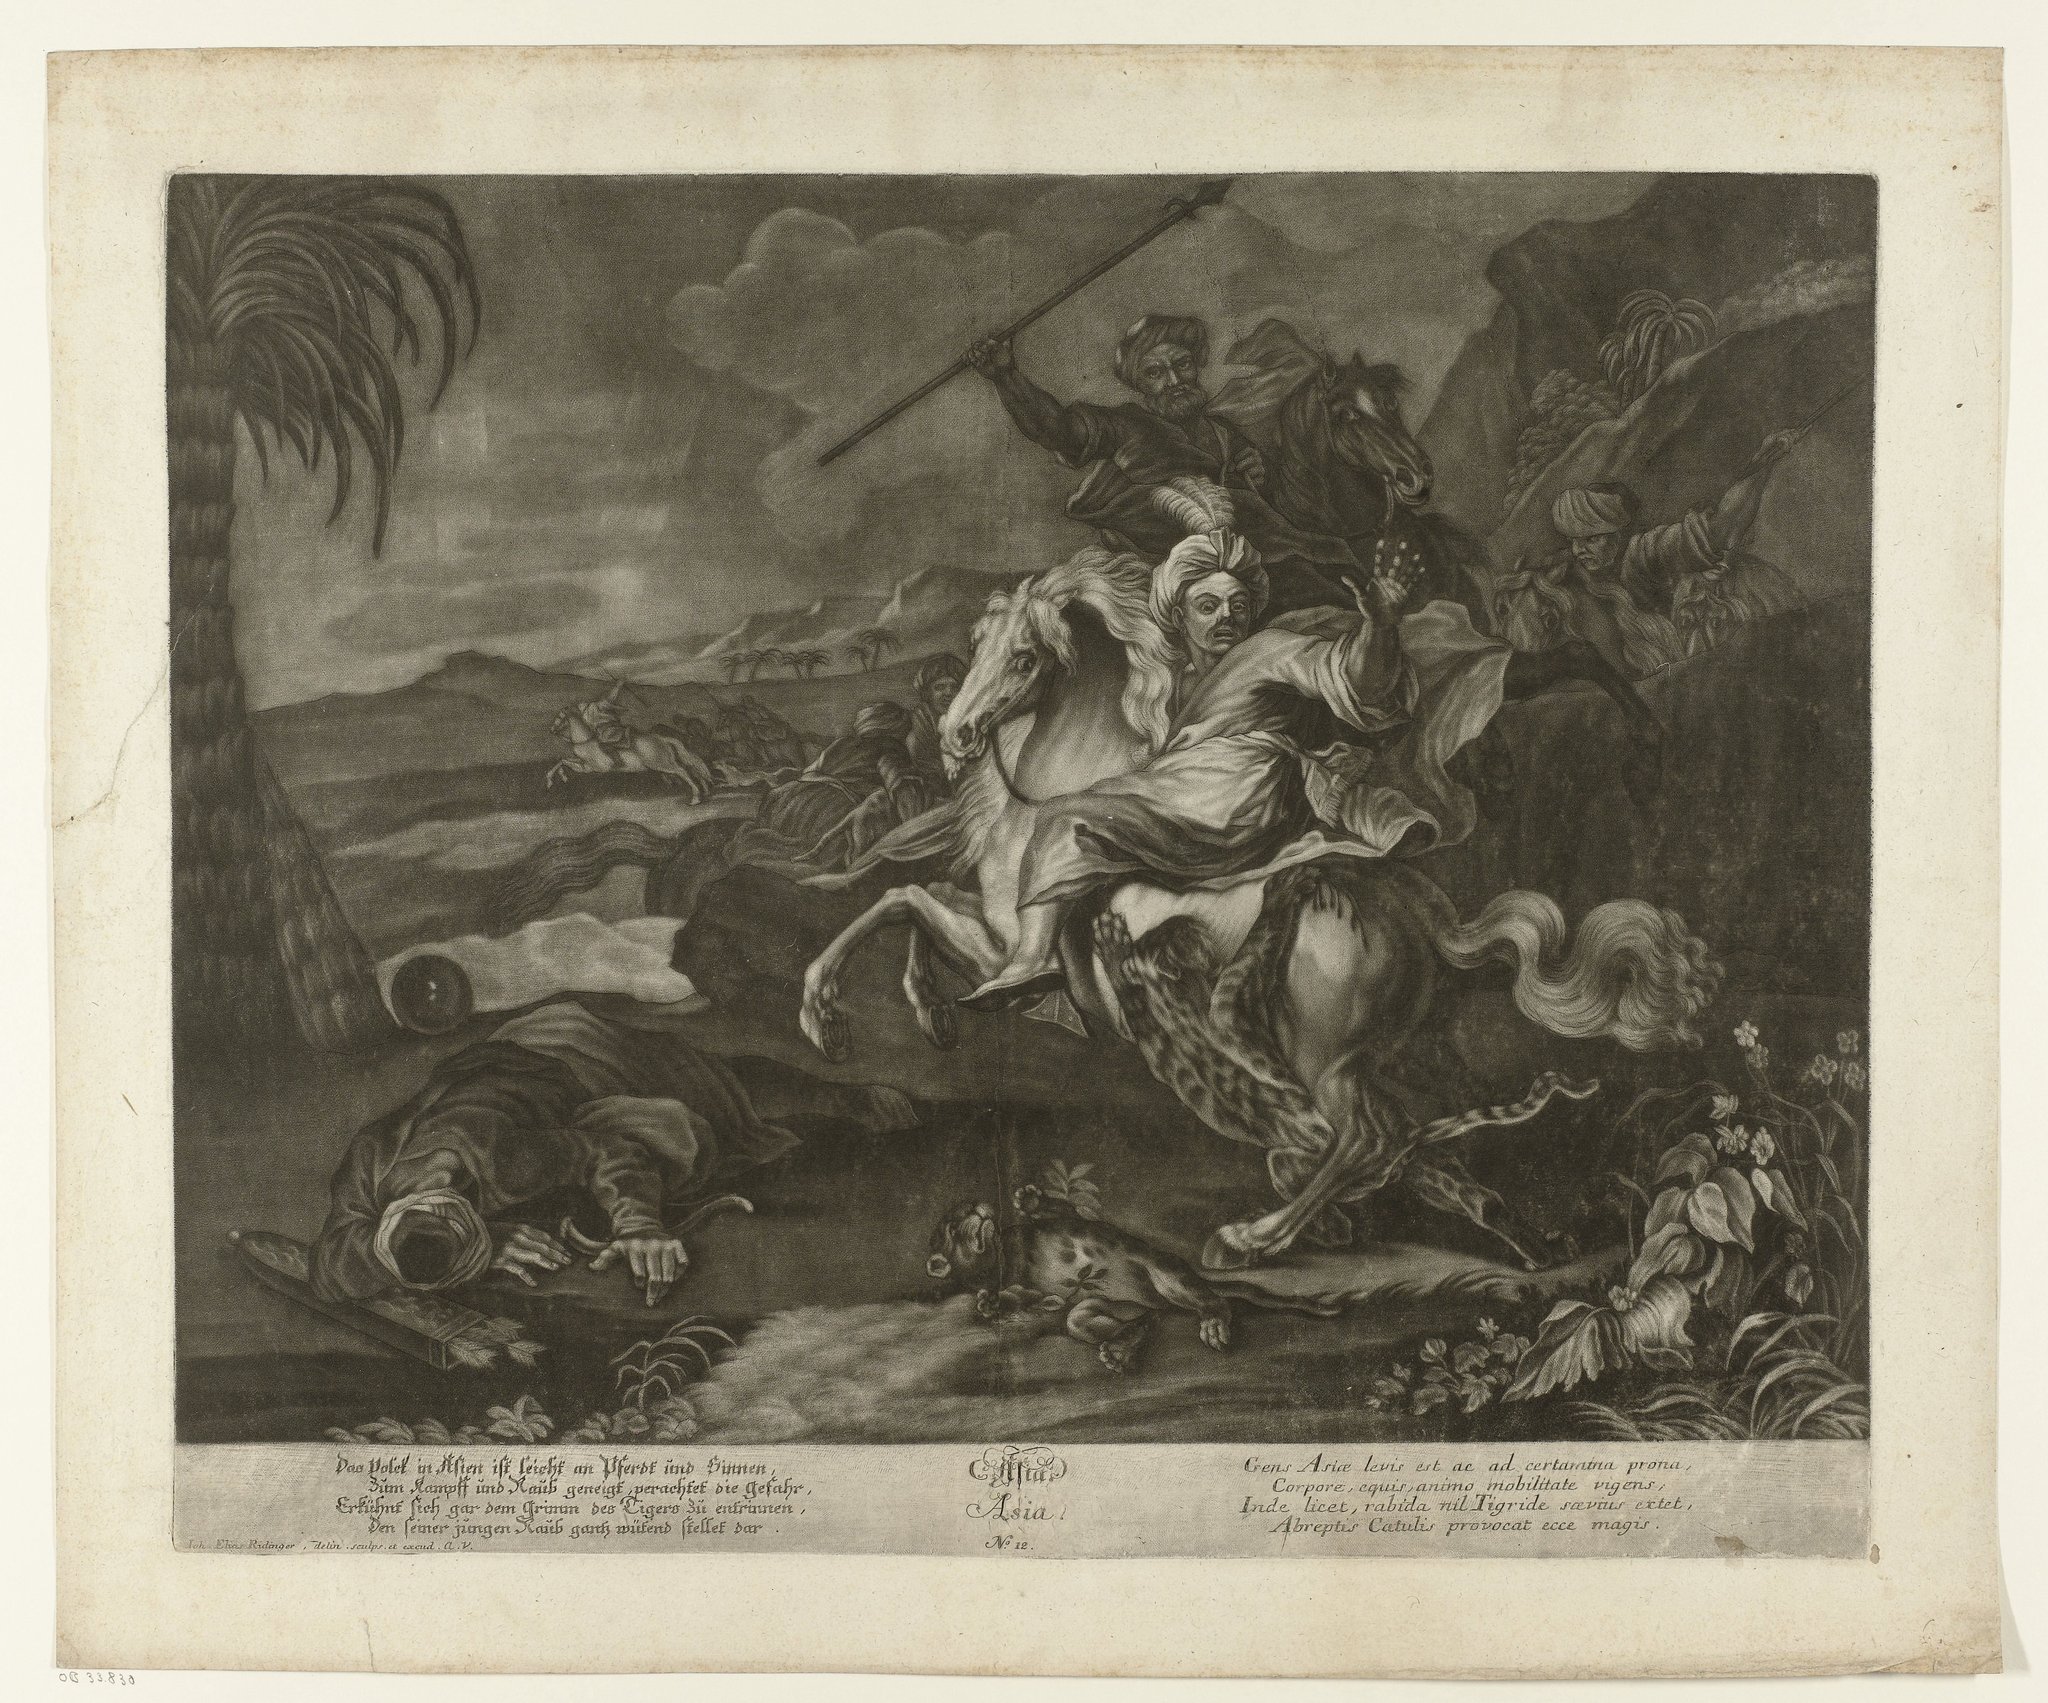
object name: print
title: Asia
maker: johann elias ridinger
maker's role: draughtsman, painter, print maker, publisher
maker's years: 1698-1767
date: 1708-1767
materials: paper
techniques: etching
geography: augsburg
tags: beasts of prey, predatory animals: leopard, asia represented allegorically; 'asia' (ripa), hunt ~ predatory animals (fox, lion)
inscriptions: collector's mark: Lugt 240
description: AziË gesymboliseerd als een jacht op luipaarden